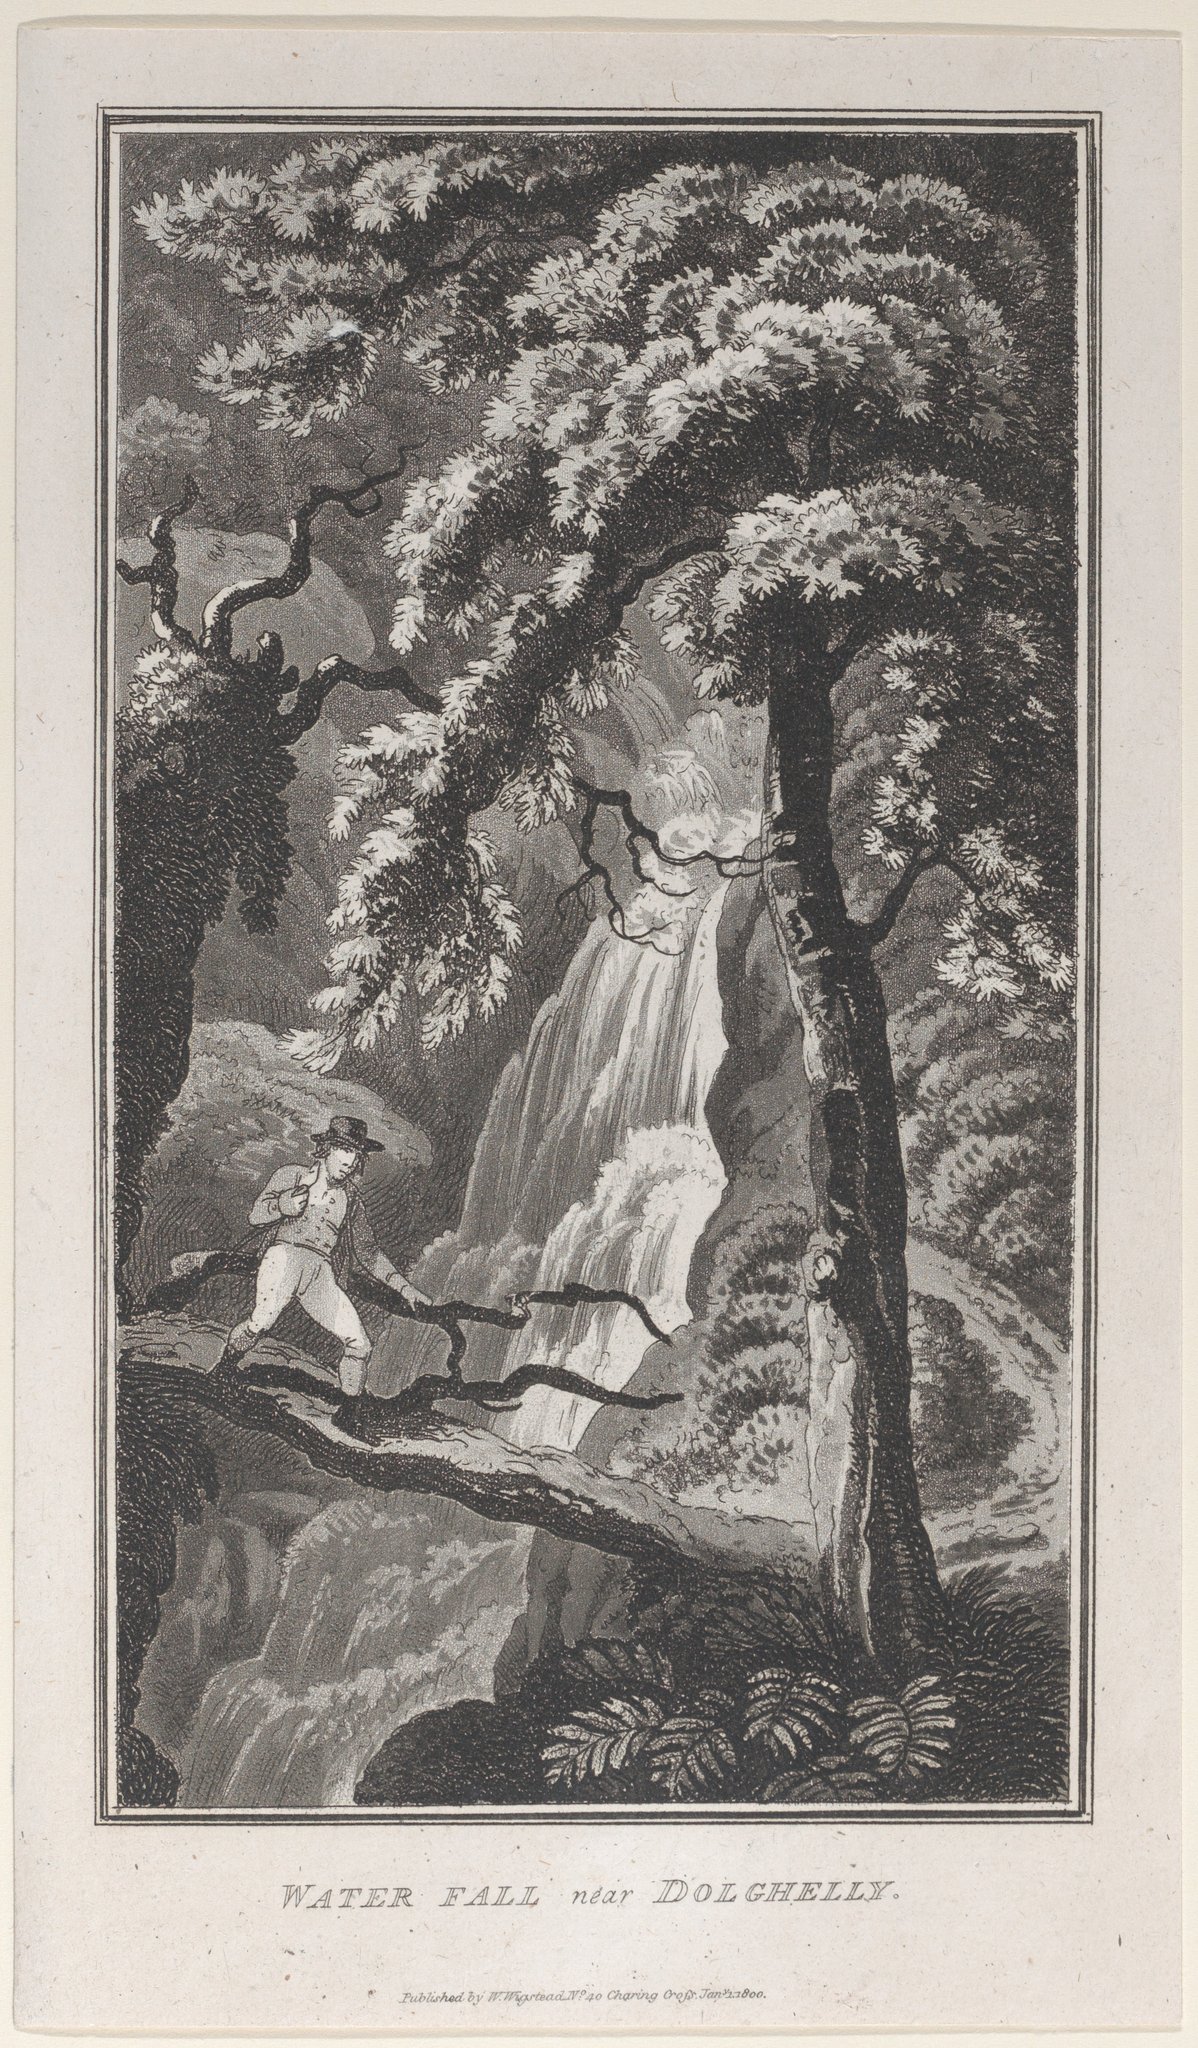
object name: print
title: Tintern Abbey, from "Remarks on a Tour to North and South Wales, in the year 1797"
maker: john hill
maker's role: artist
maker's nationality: british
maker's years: 1714-1775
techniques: aquatint, etching